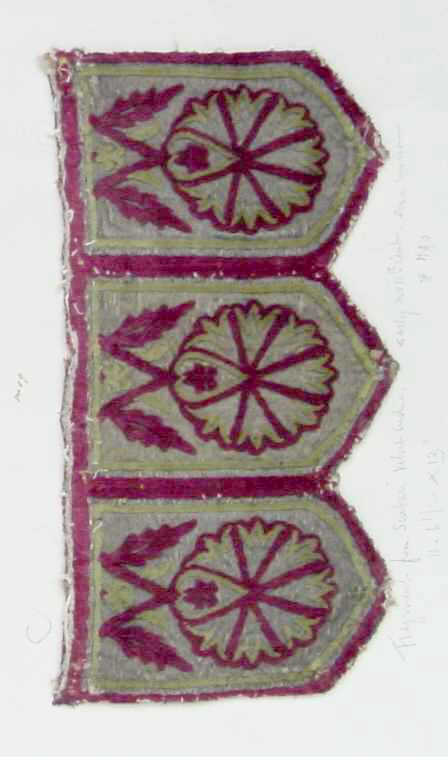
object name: textile fragment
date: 1601-1700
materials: metal thread, silk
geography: turkey